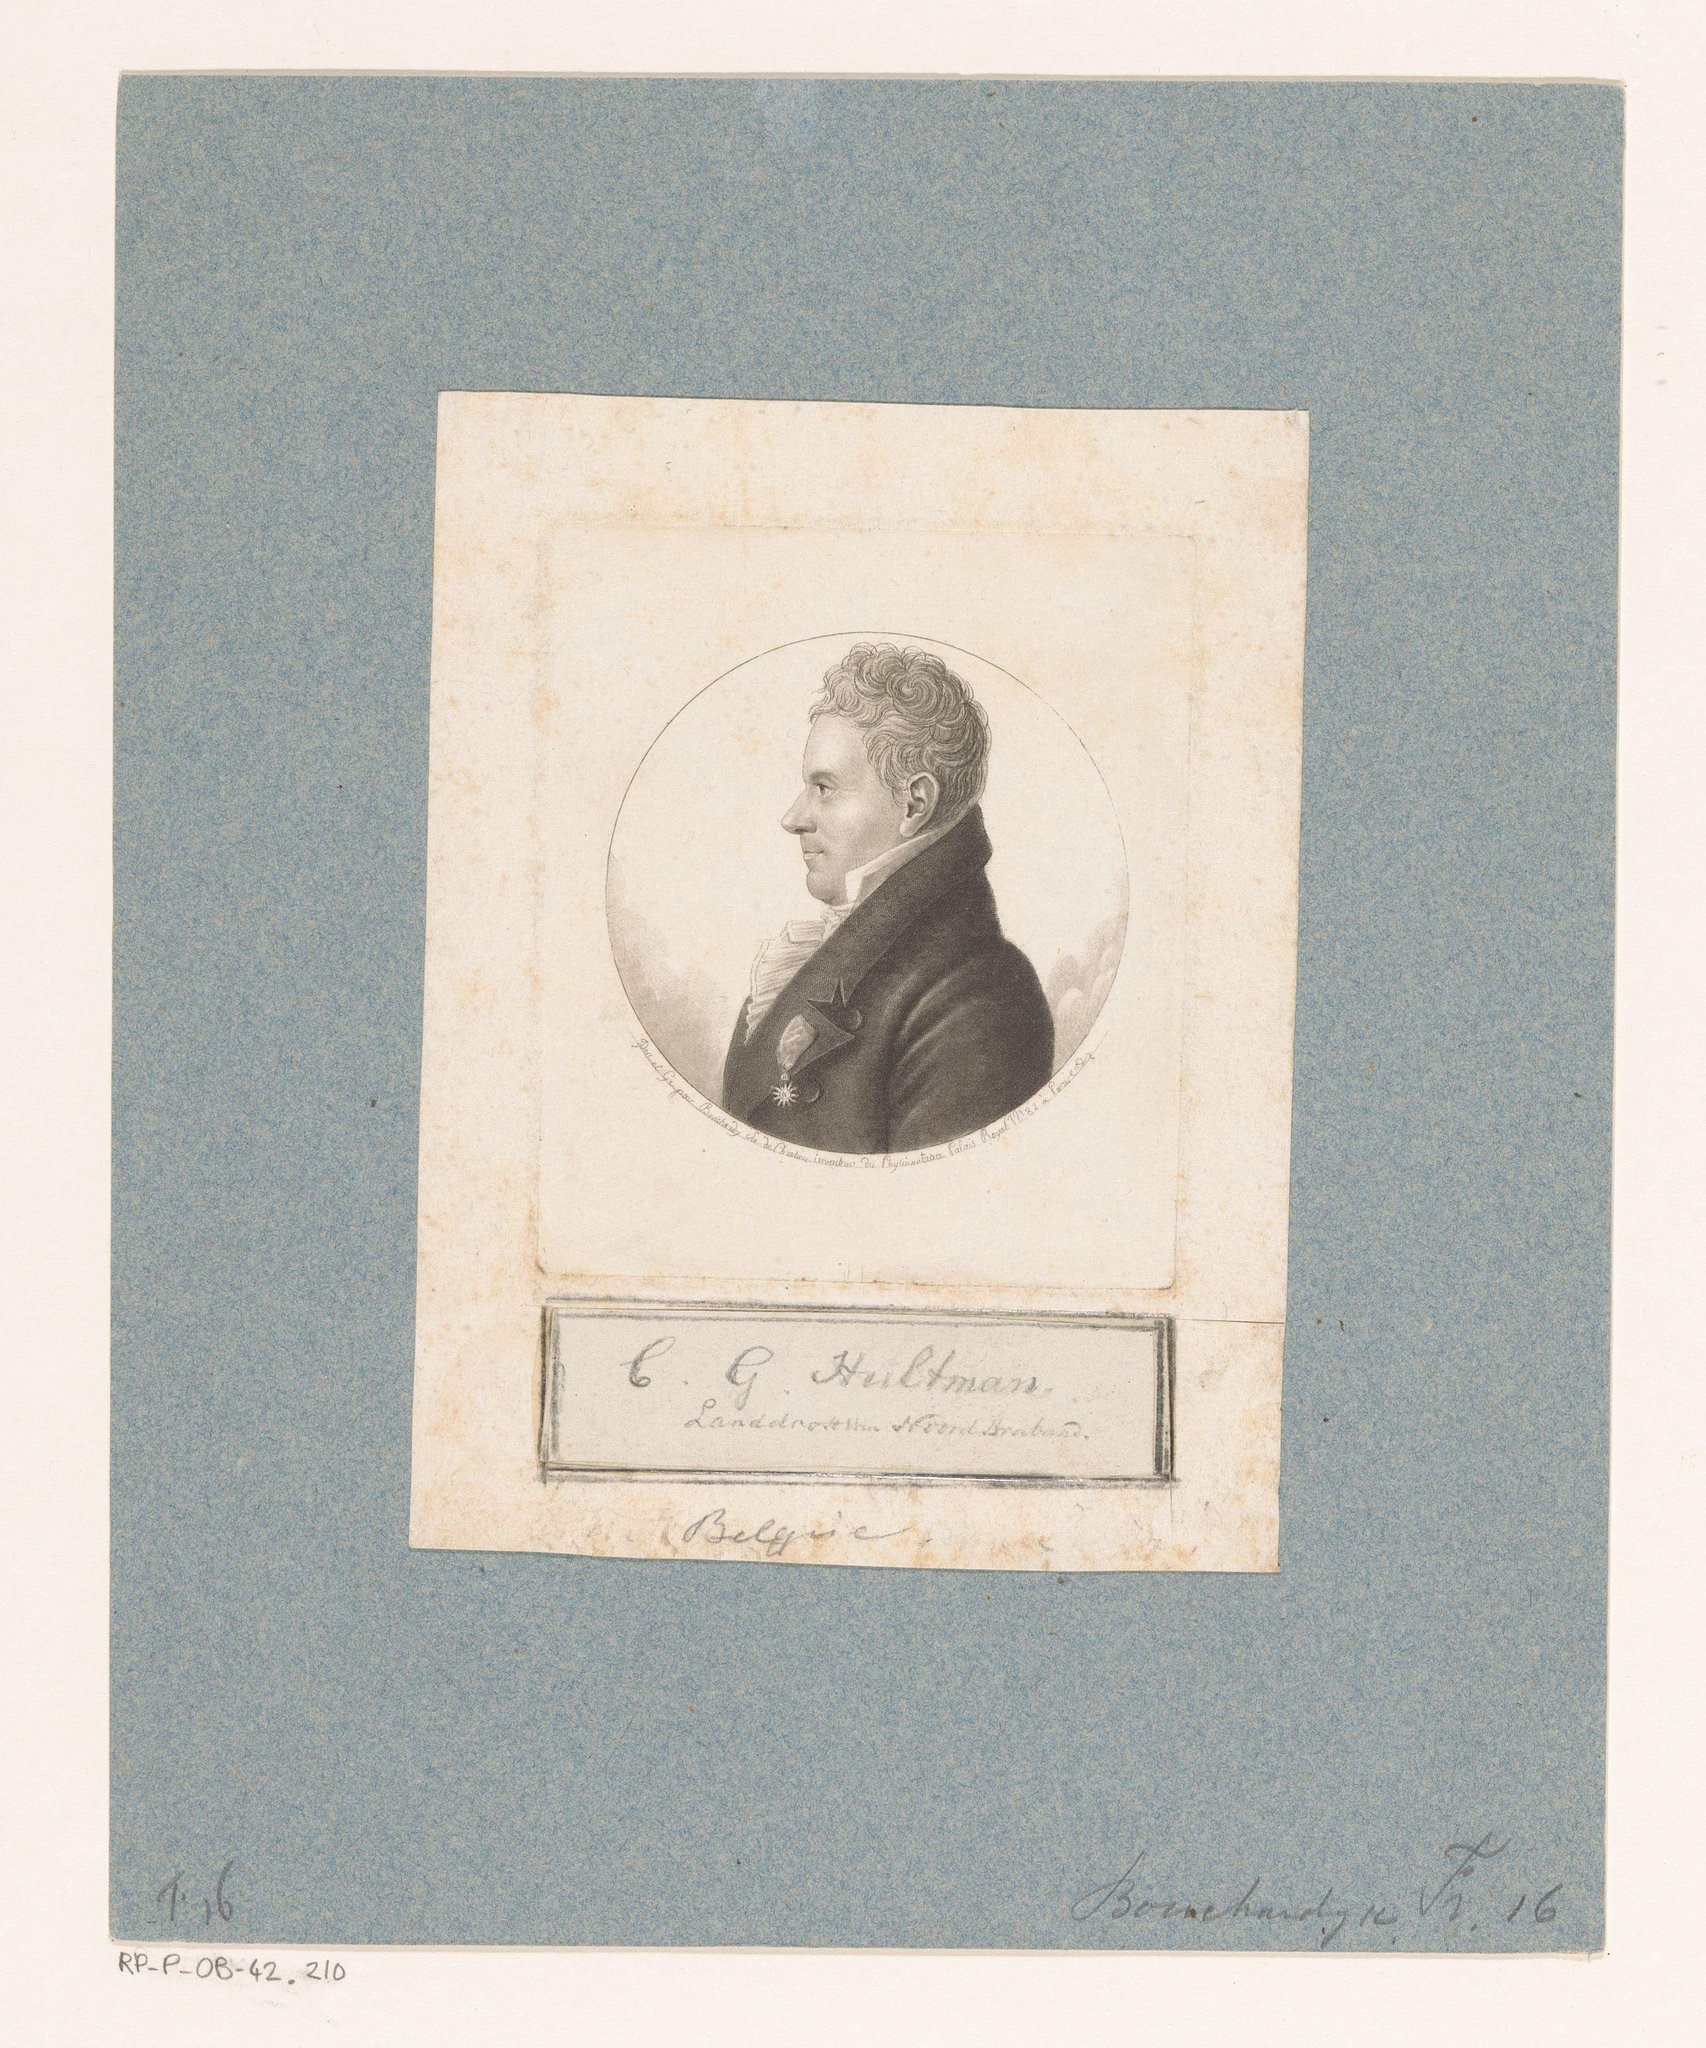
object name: print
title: Portret van Carel Gerard Hultman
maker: etienne bouchardy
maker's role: print maker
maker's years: 1797-1849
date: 1807-1849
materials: paper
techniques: aquatint, etching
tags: den bosch, carel gerard hultman, historical persons, lawyer, attorney at law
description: Dit portret werd volgens het opschrift vervaardigd met behulp van een physionotrace, waarmee de contouren van een gezicht op een stuk papier konden worden overgebracht.